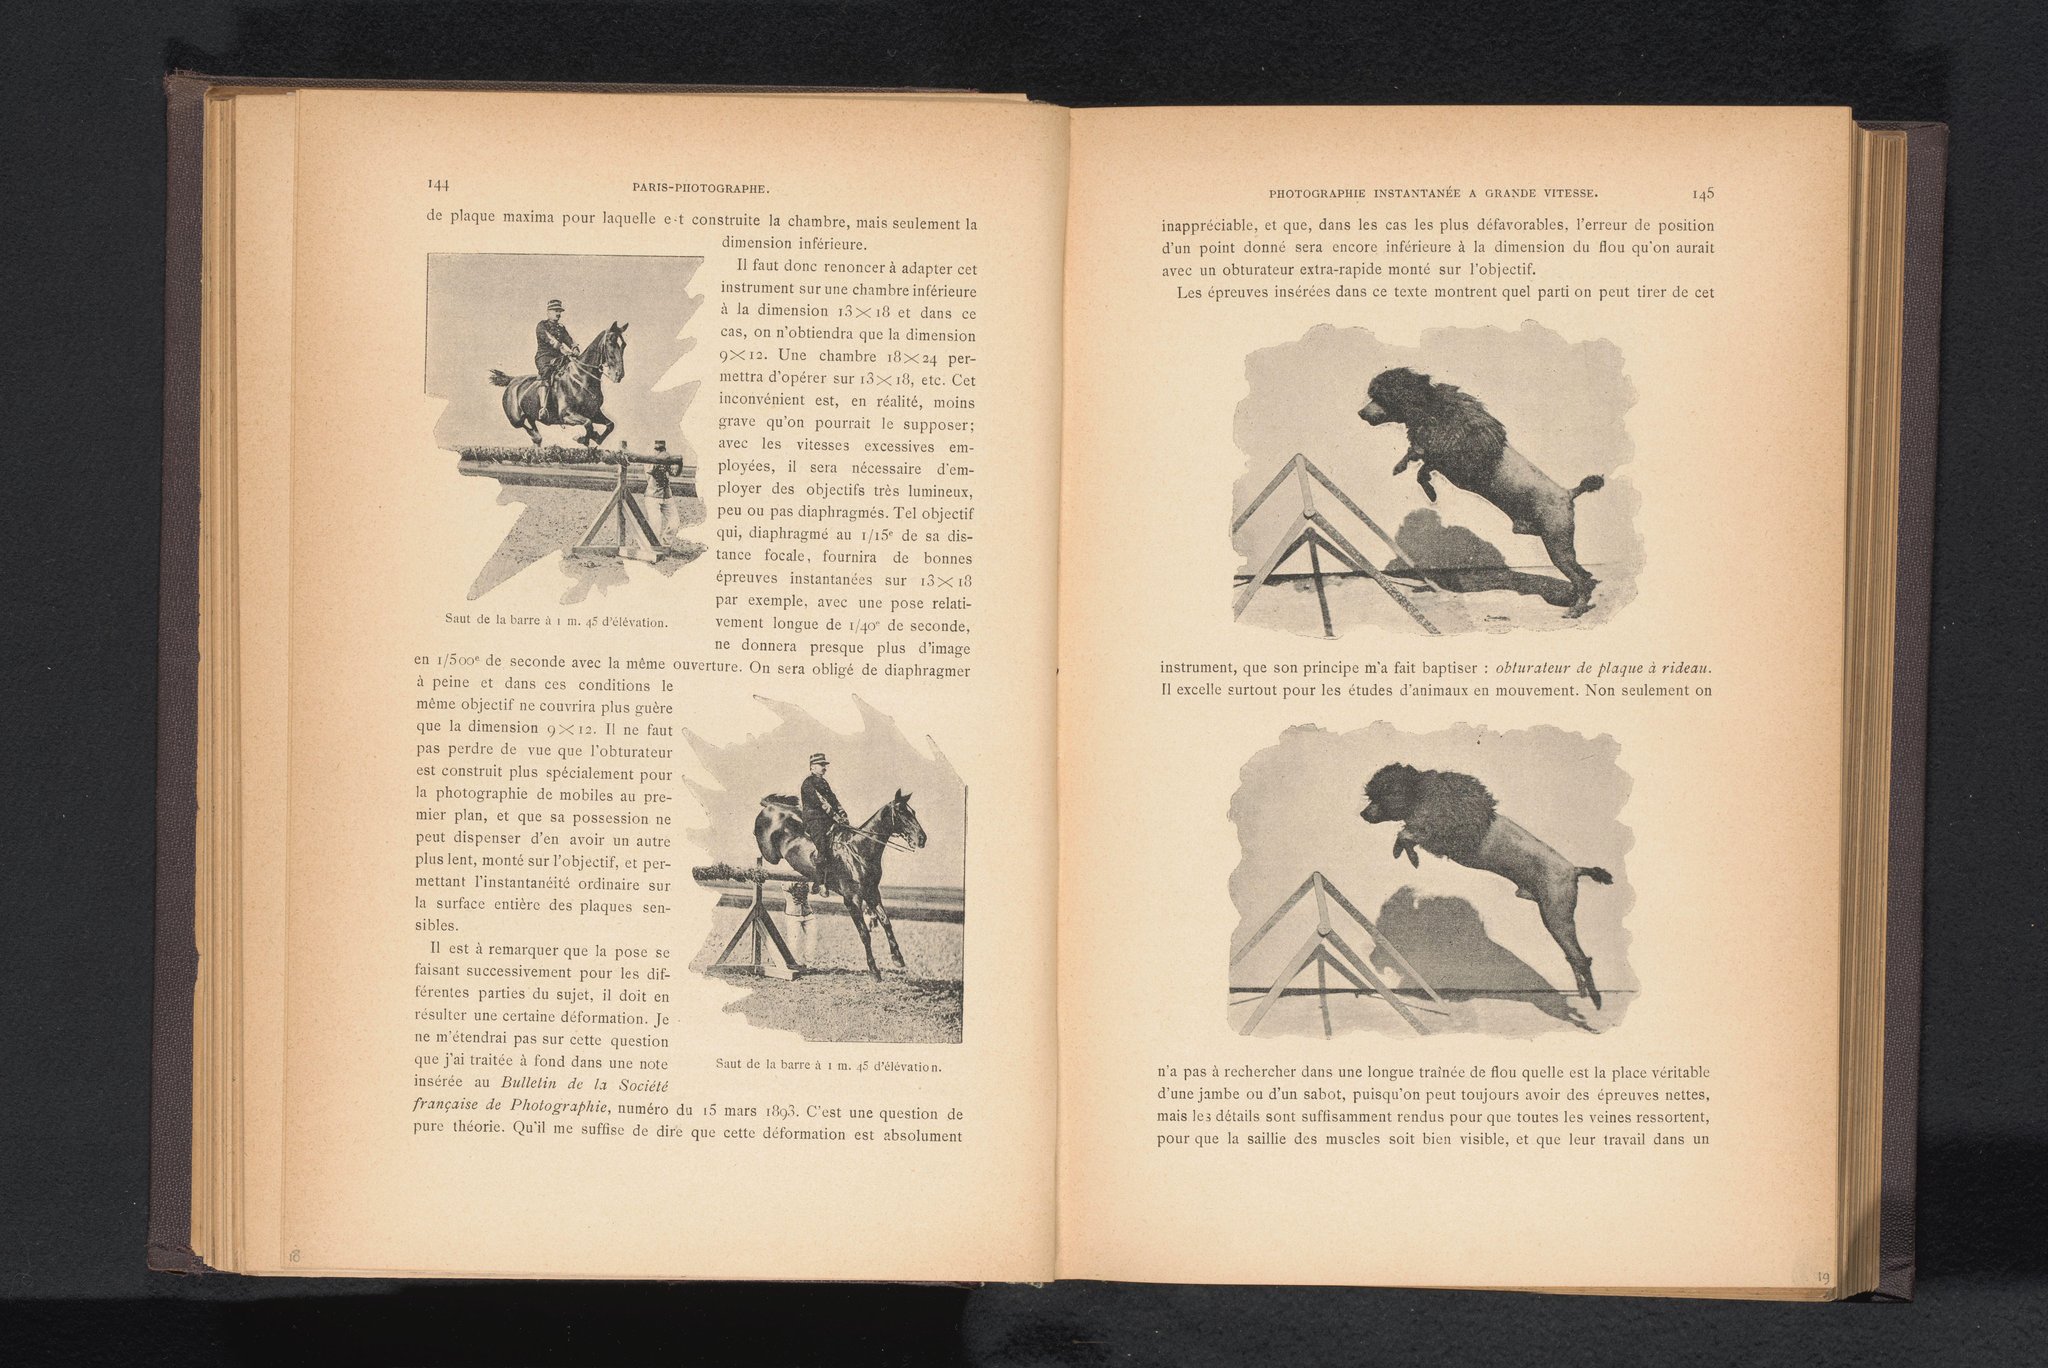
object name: page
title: Tweemaal een man op een springend paard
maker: Anonymous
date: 1883-1893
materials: paper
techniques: autotype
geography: france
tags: riding a horse, ass, or mule; rider, horseman, jumping (horse in motion), horse